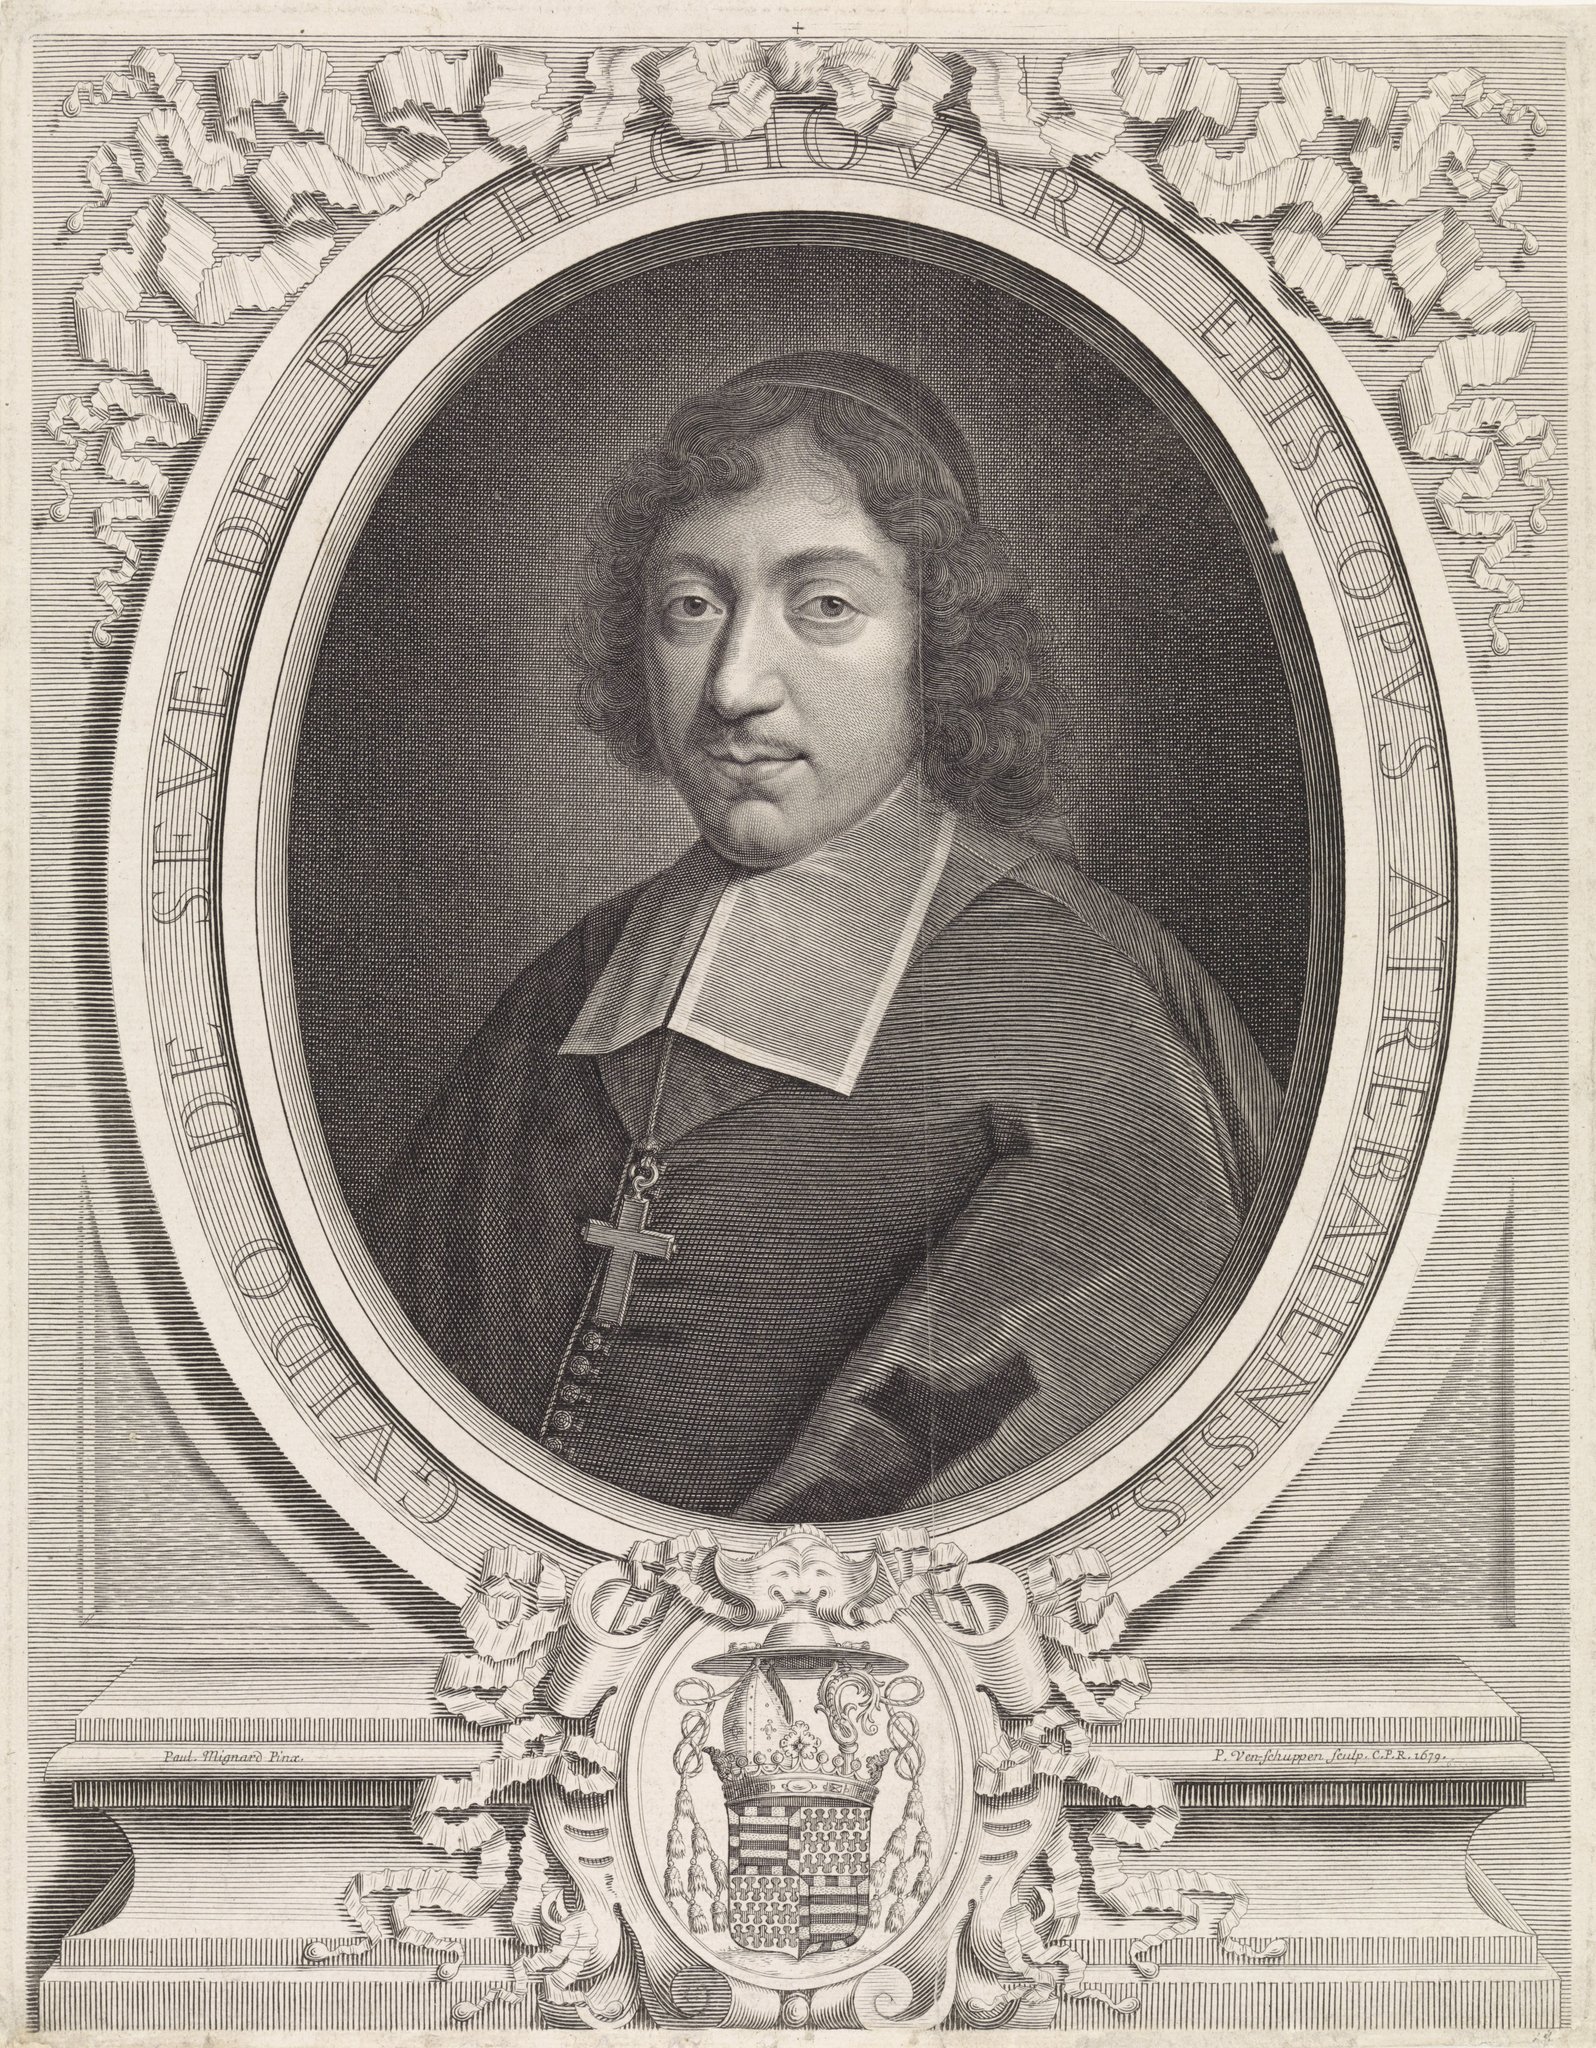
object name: print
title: Portret van Guy de Sève de Rochechouart, bisschop van Arras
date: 1606-1679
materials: paper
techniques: engraving, etching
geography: paris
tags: bisschop, abt, guy de sève de rochechouart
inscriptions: collector's mark: Lugt 240